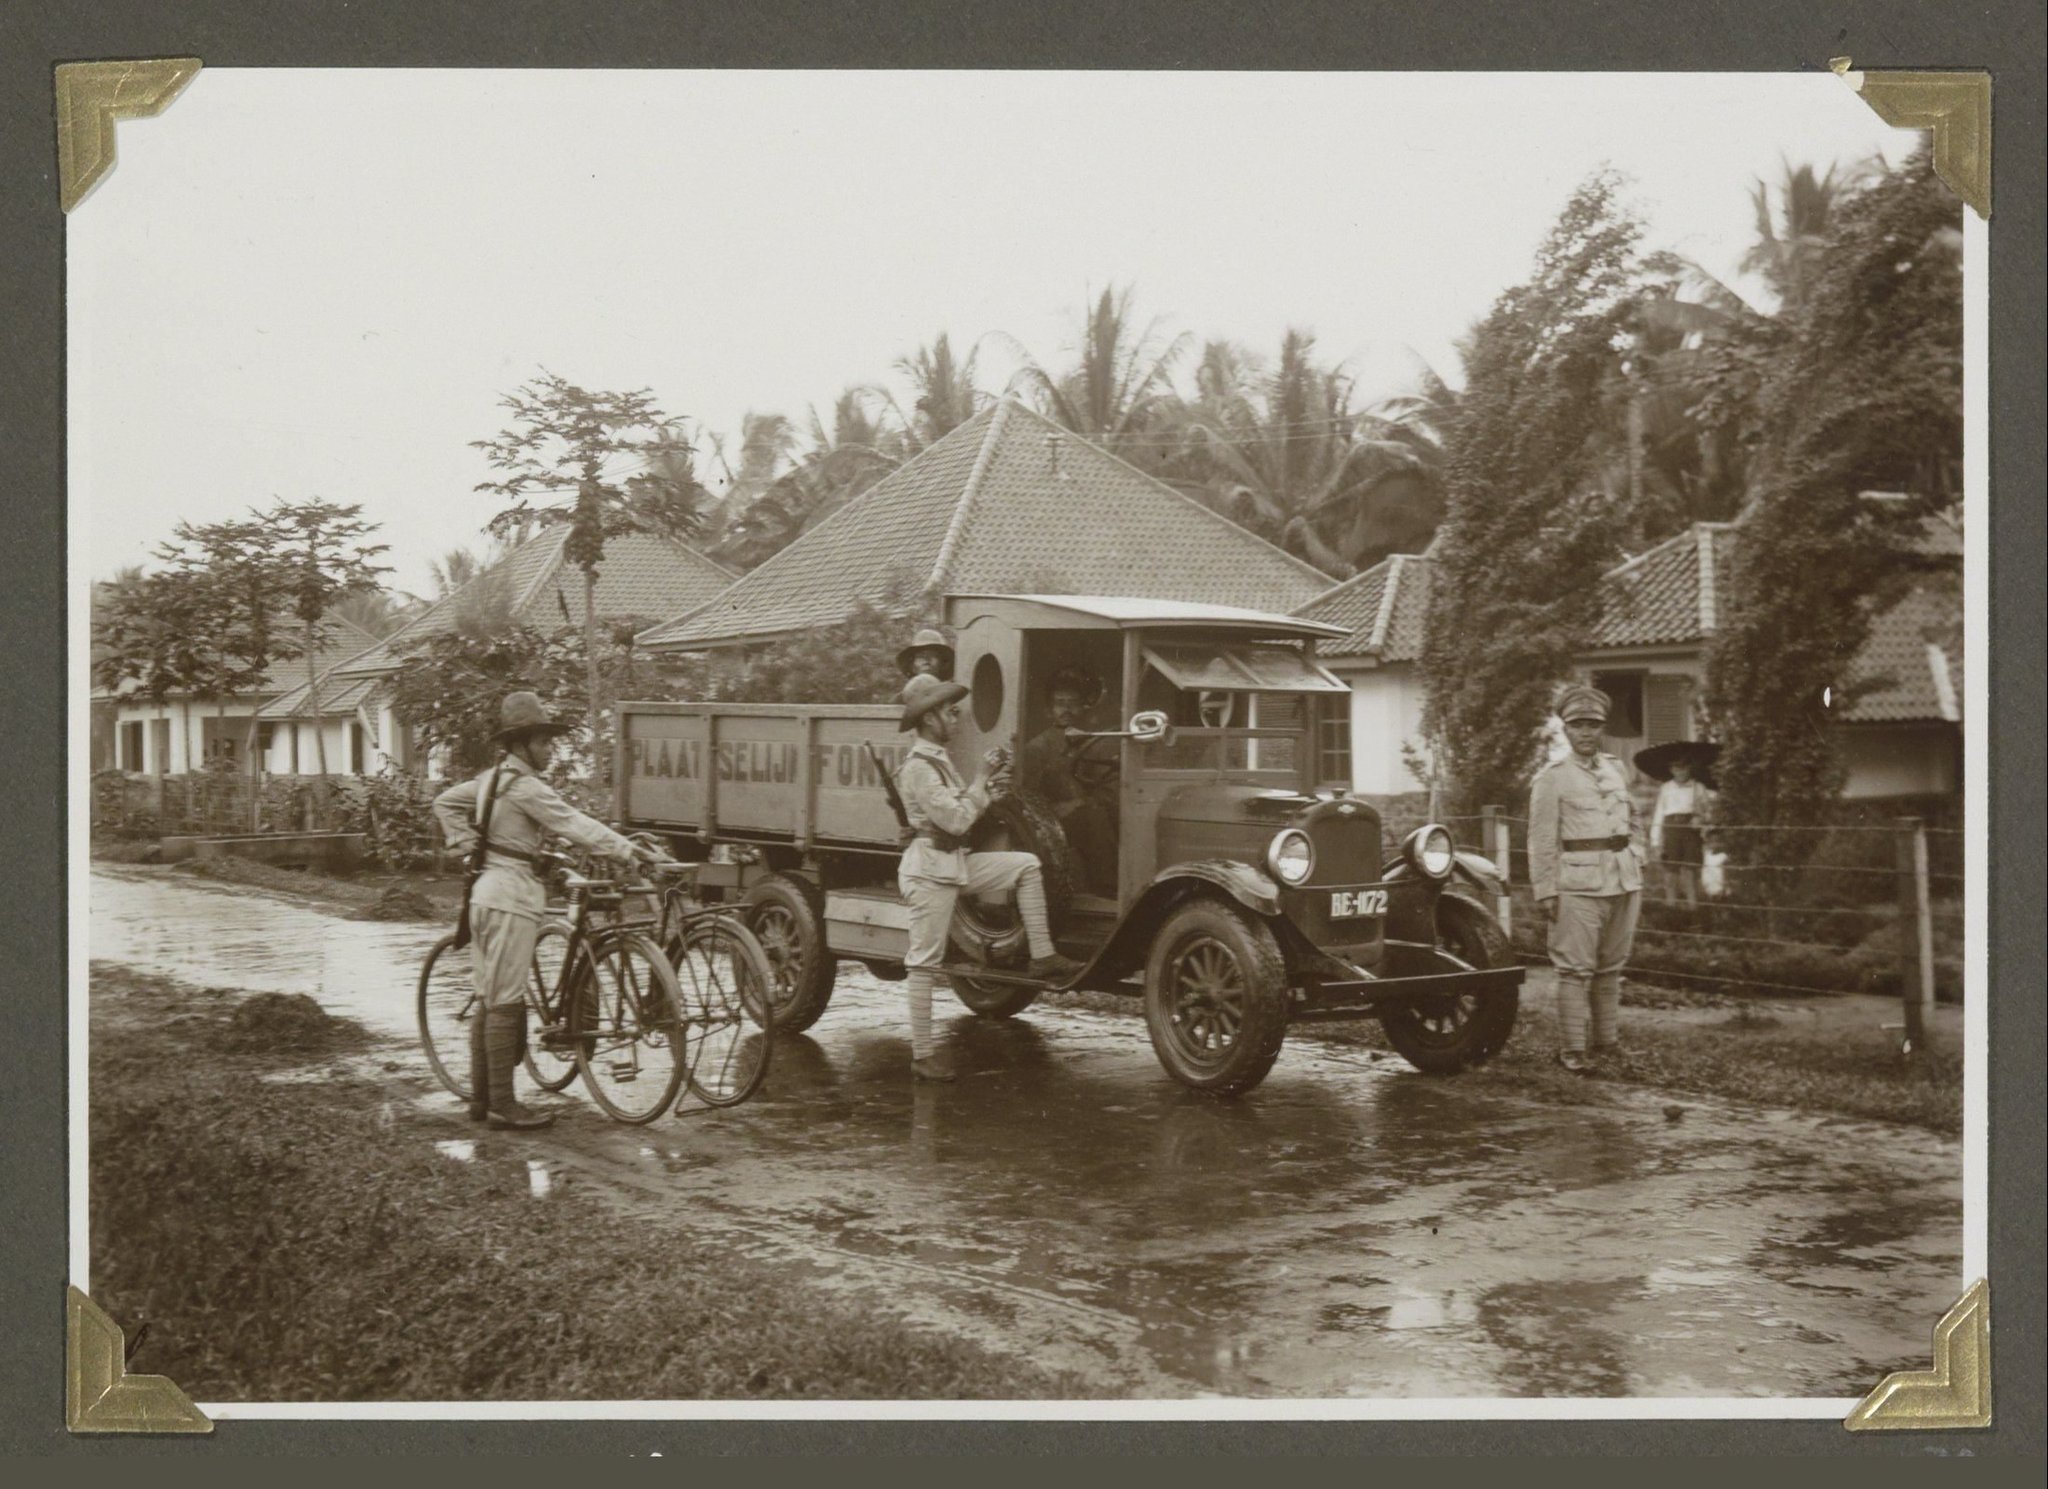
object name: photograph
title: Ma Sopir heeft geen rijbewijs en wordt derhalve verbaliseerd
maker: Anonymous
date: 1932-1933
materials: photographic support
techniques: gelatin silver print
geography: lampung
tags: truck, van, police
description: Onderdeel van Herinneringsalbum voor F.J. Junius, vertrekkend resident van Lampong (Zuid-Sumatra).